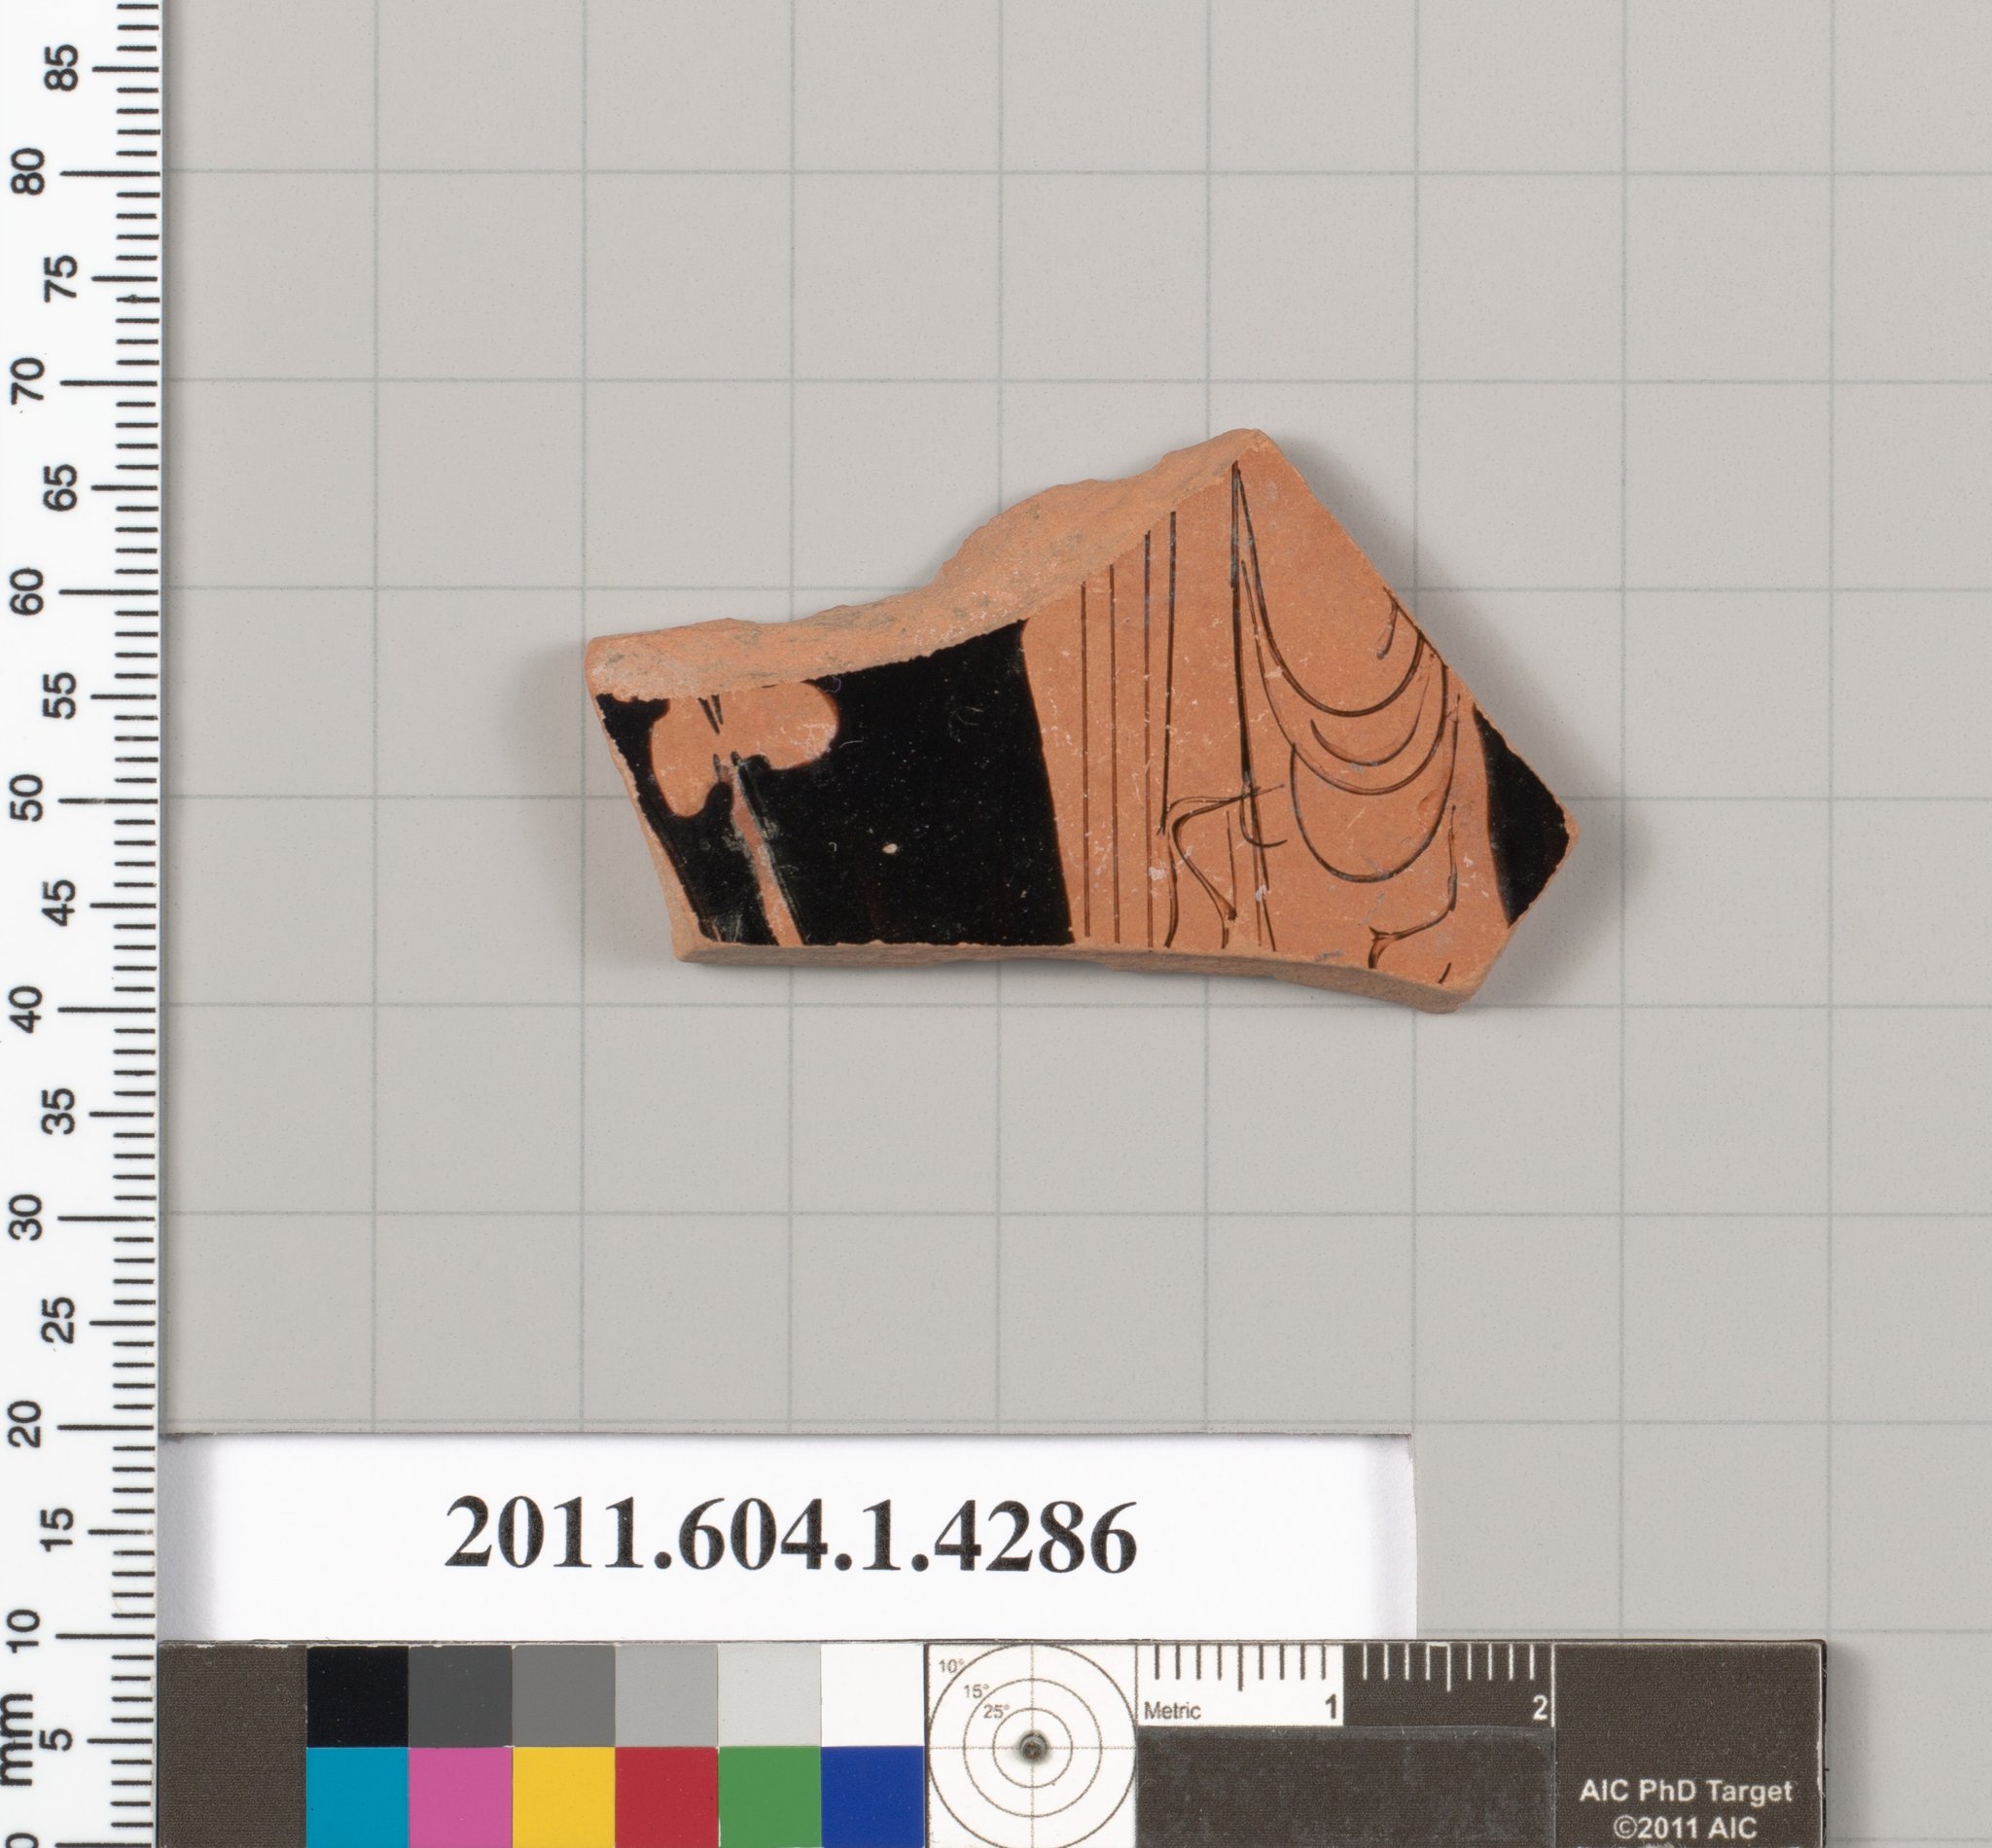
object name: kylix fragment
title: Terracotta fragment of a kylix (drinking cup)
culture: greek, attic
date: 475-451 BCE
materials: terracotta